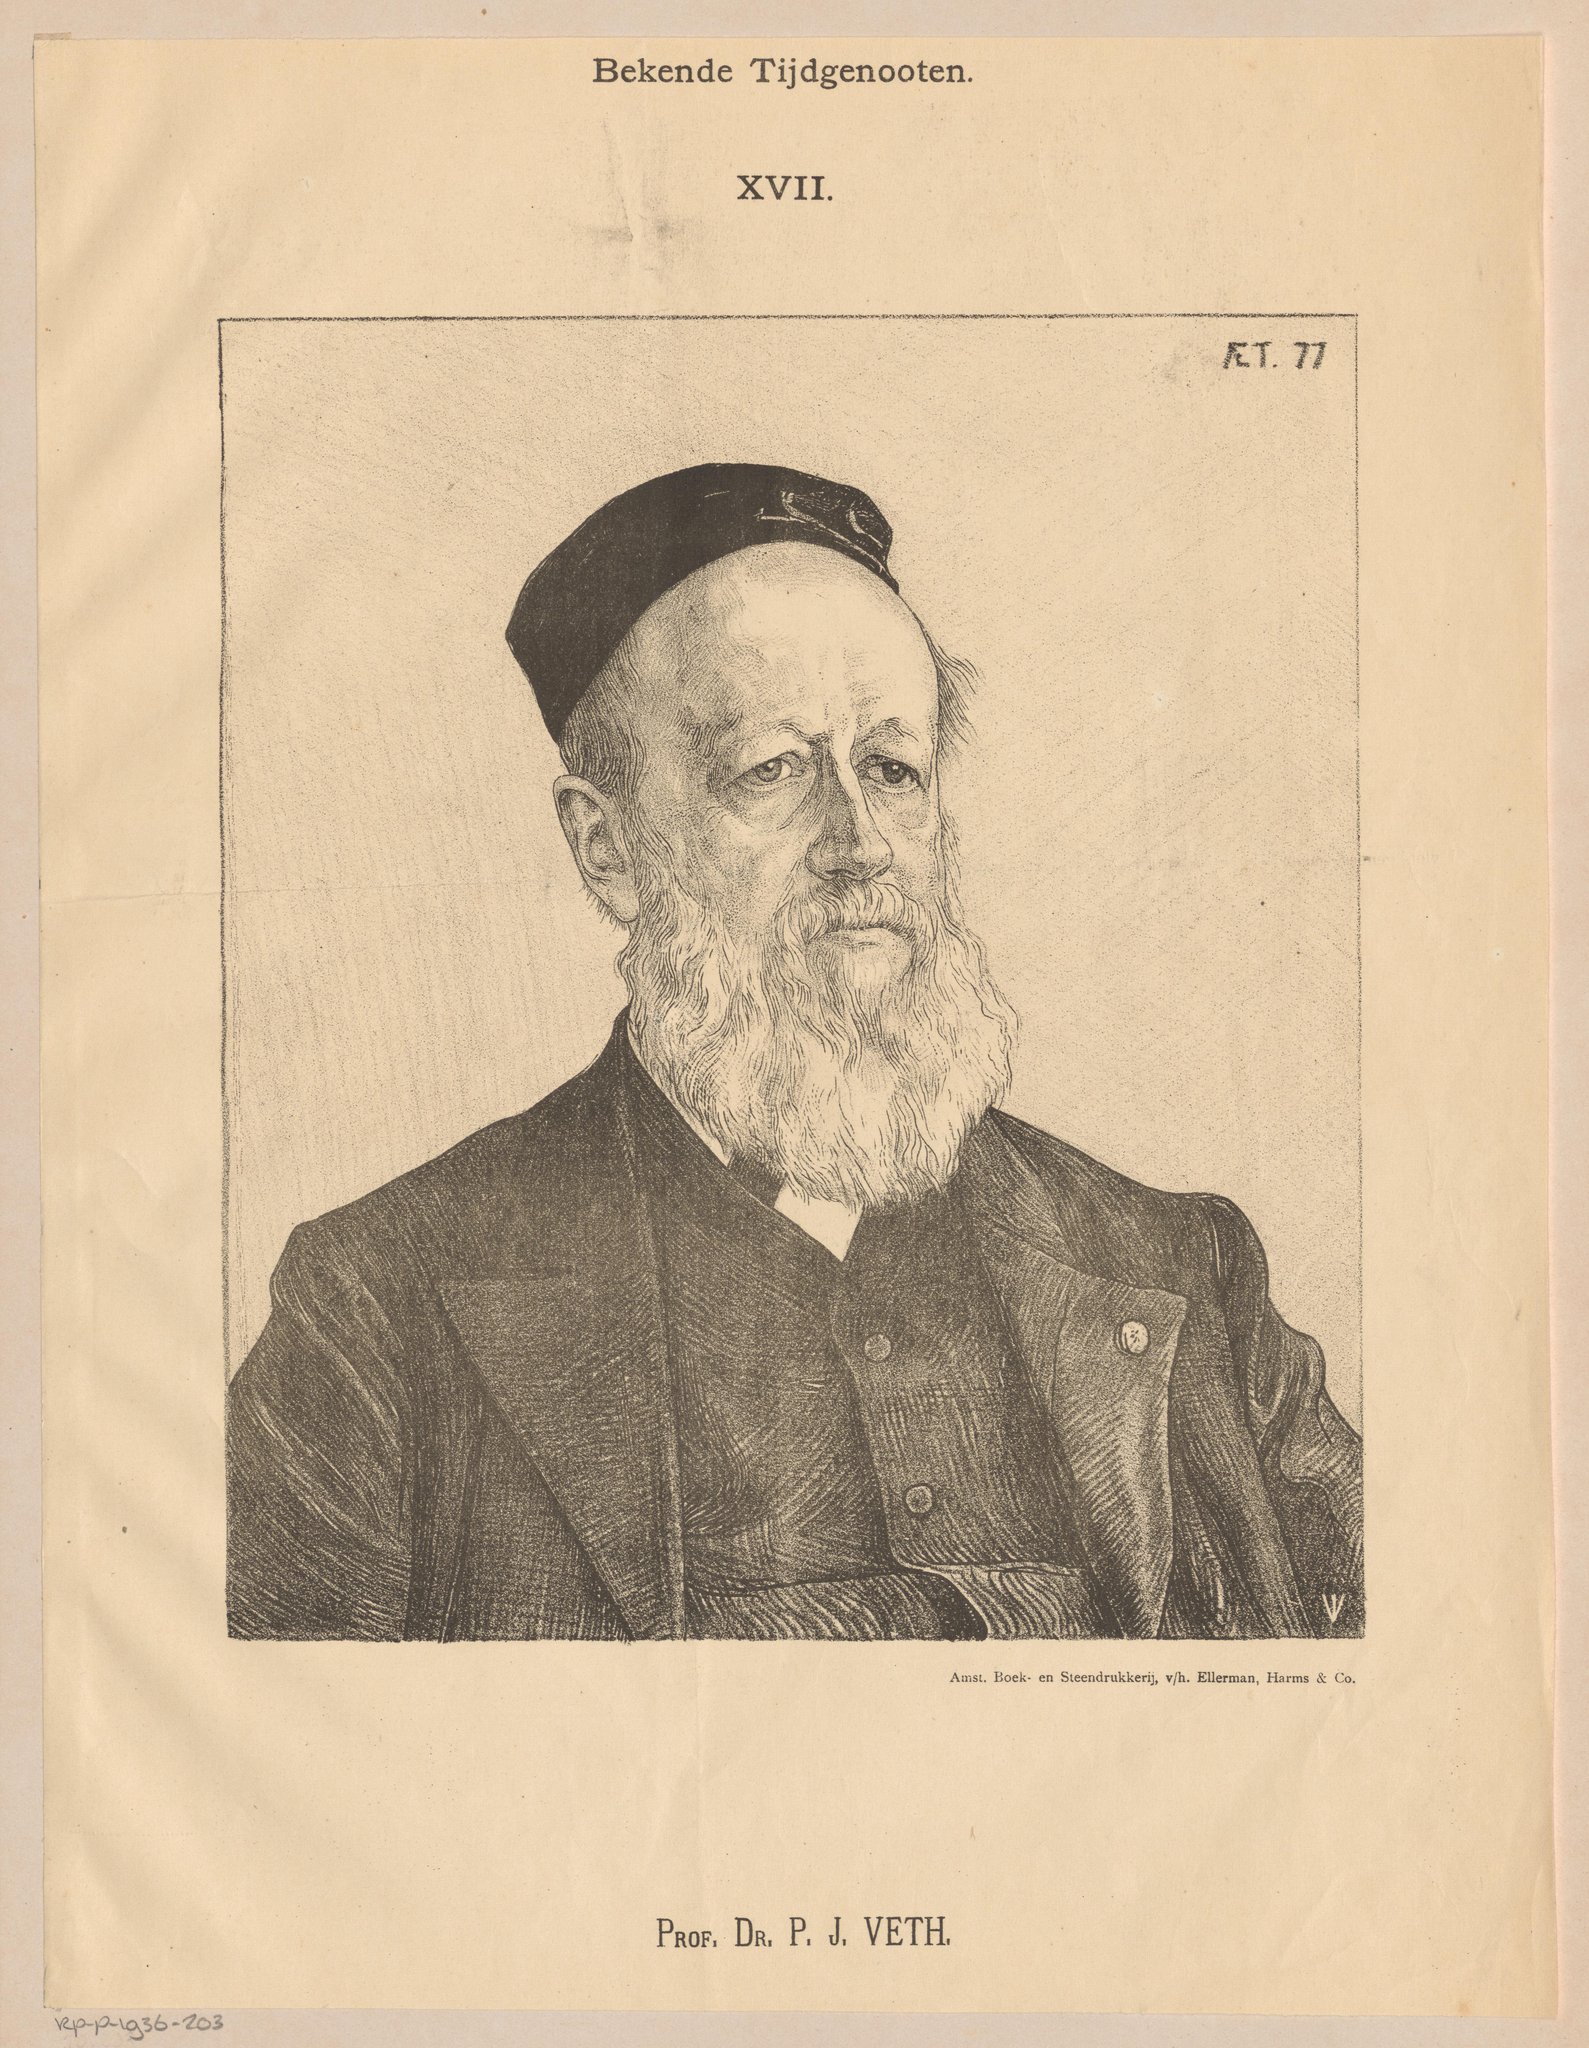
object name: print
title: Bekende tijdgenooten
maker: jan veth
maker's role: designer, draughtsman, painter, print maker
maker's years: 1864-1925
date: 1892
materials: paper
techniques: lithograph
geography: amsterdam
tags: dordrecht, scholar, philosopher, historical persons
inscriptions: collector's mark: Lugt 2228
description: Deze prent werd uitgegeven als bijvoegsel van De Amsterdammer op 16 oktober 1892.